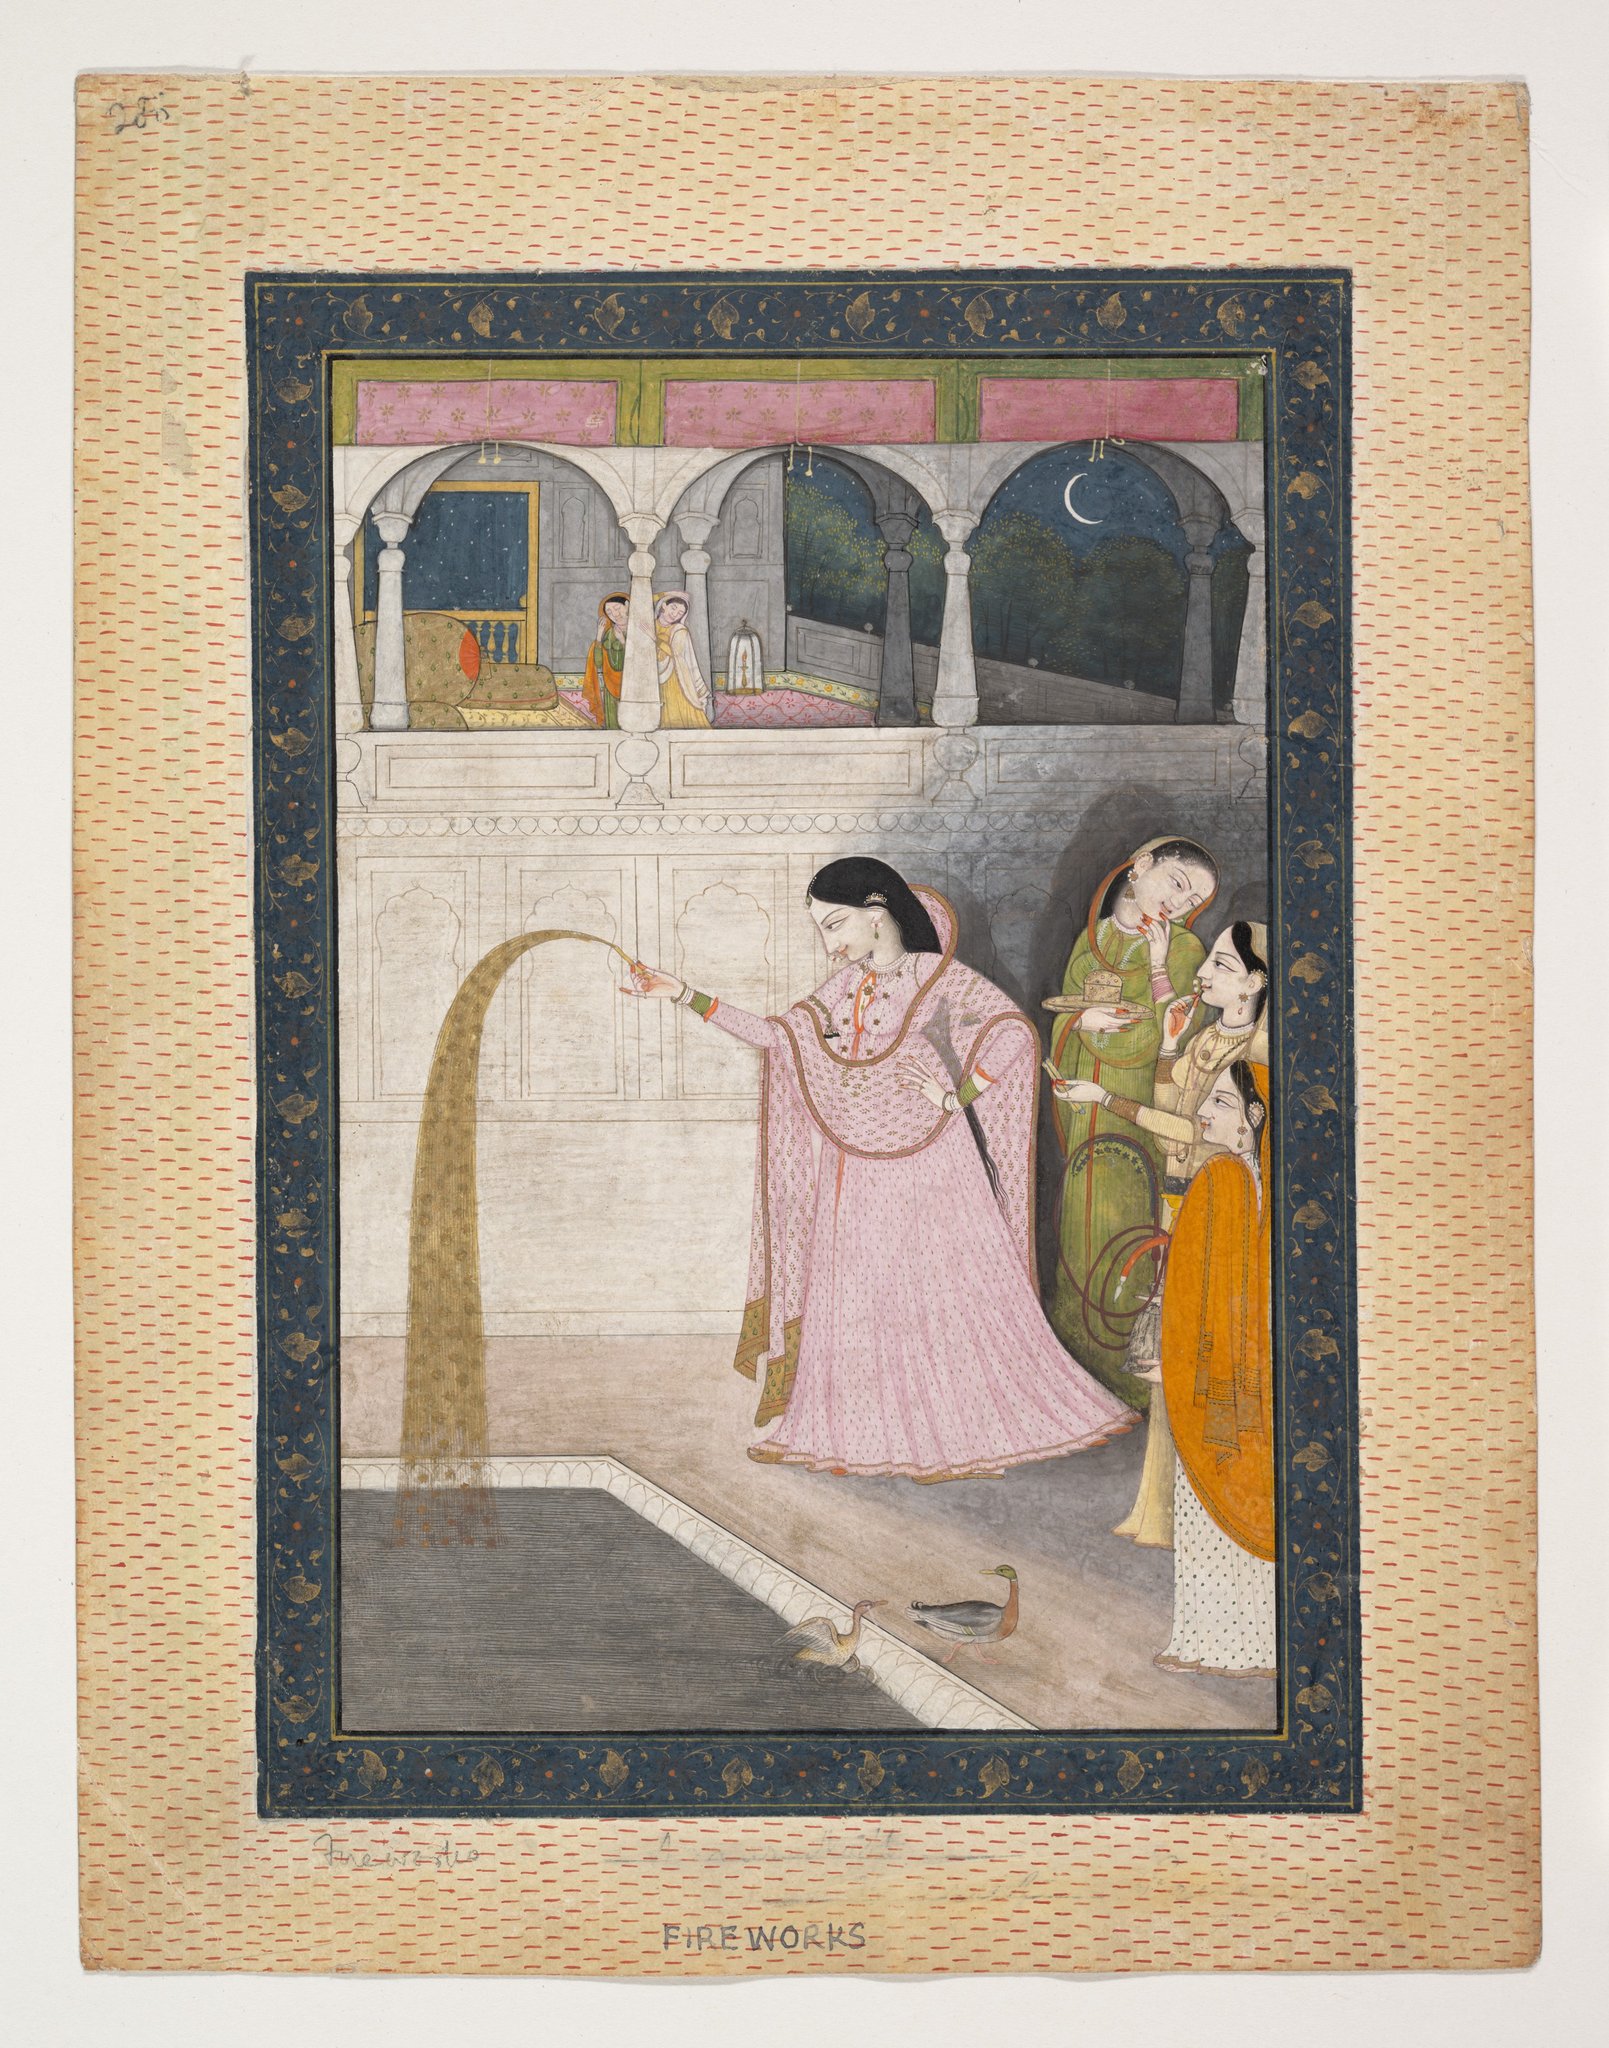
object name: painting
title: Lady Holding a Sparkler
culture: indian, kangra, punjab hills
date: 1800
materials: gold, ink, paper, silver, watercolor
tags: ducks,women,fireworks